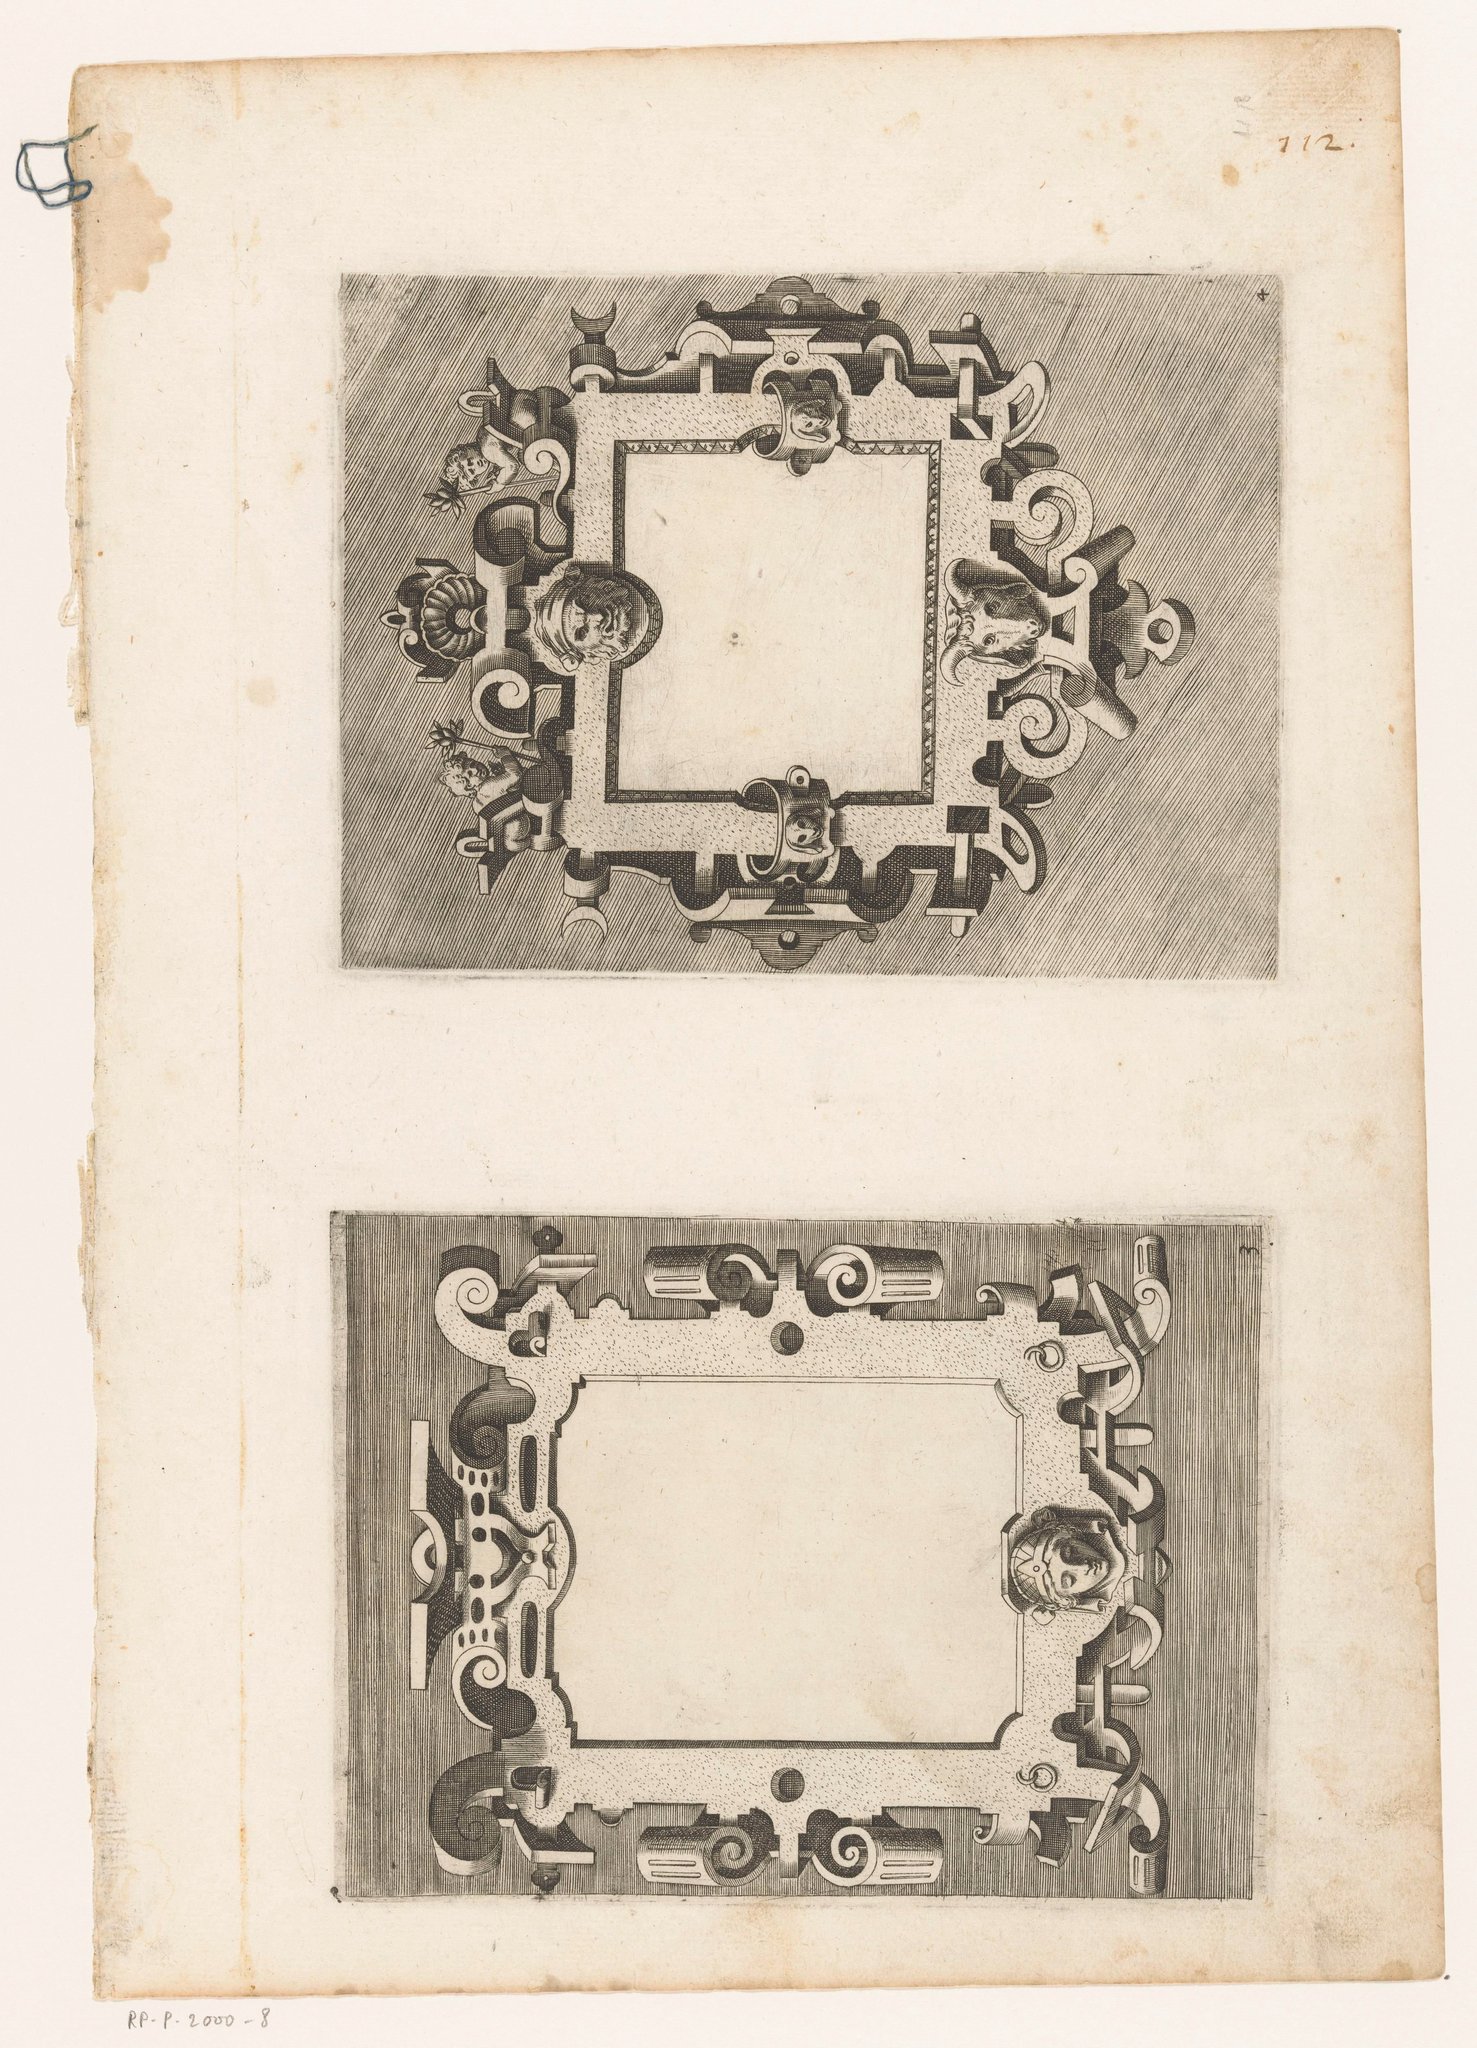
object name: print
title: Cartouches met maskers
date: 1555-1572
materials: paper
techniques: etching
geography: italy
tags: ornaments ~ art (+ framing decorations), mask, mascaron ~ ornament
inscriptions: collector's mark: Lugt 2760, collector's mark: Lugt 2228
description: Twee geornamenteerde rechthoekige cartouches op een blad. Links: Een cartouche met aan de onderzijde een vrouwelijk masker, rechts onder nummer 3. Rechts: Een cartouche met twee putti, een mannelijk masker en dierenkoppen, rechts onder nummer 4.